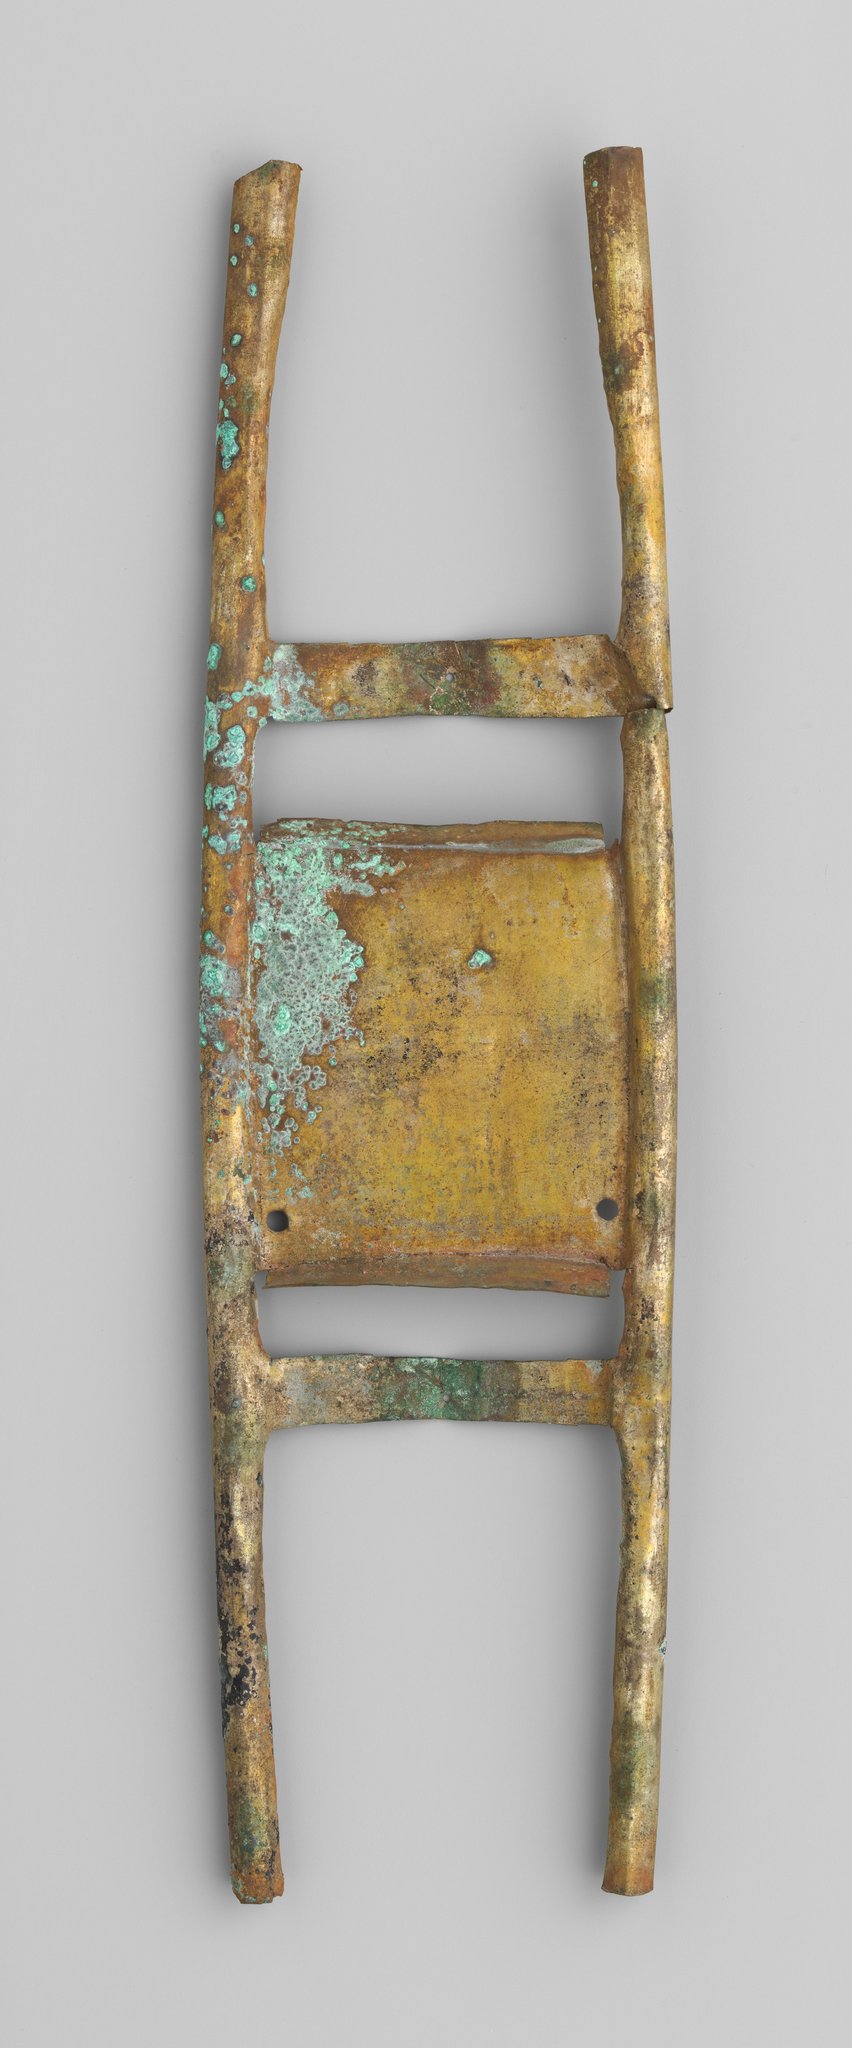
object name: litter bed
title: Miniature litter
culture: chancay or chimú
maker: chimú or chancay artist(s)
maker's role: artist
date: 1100-1470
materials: gilt silver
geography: peru